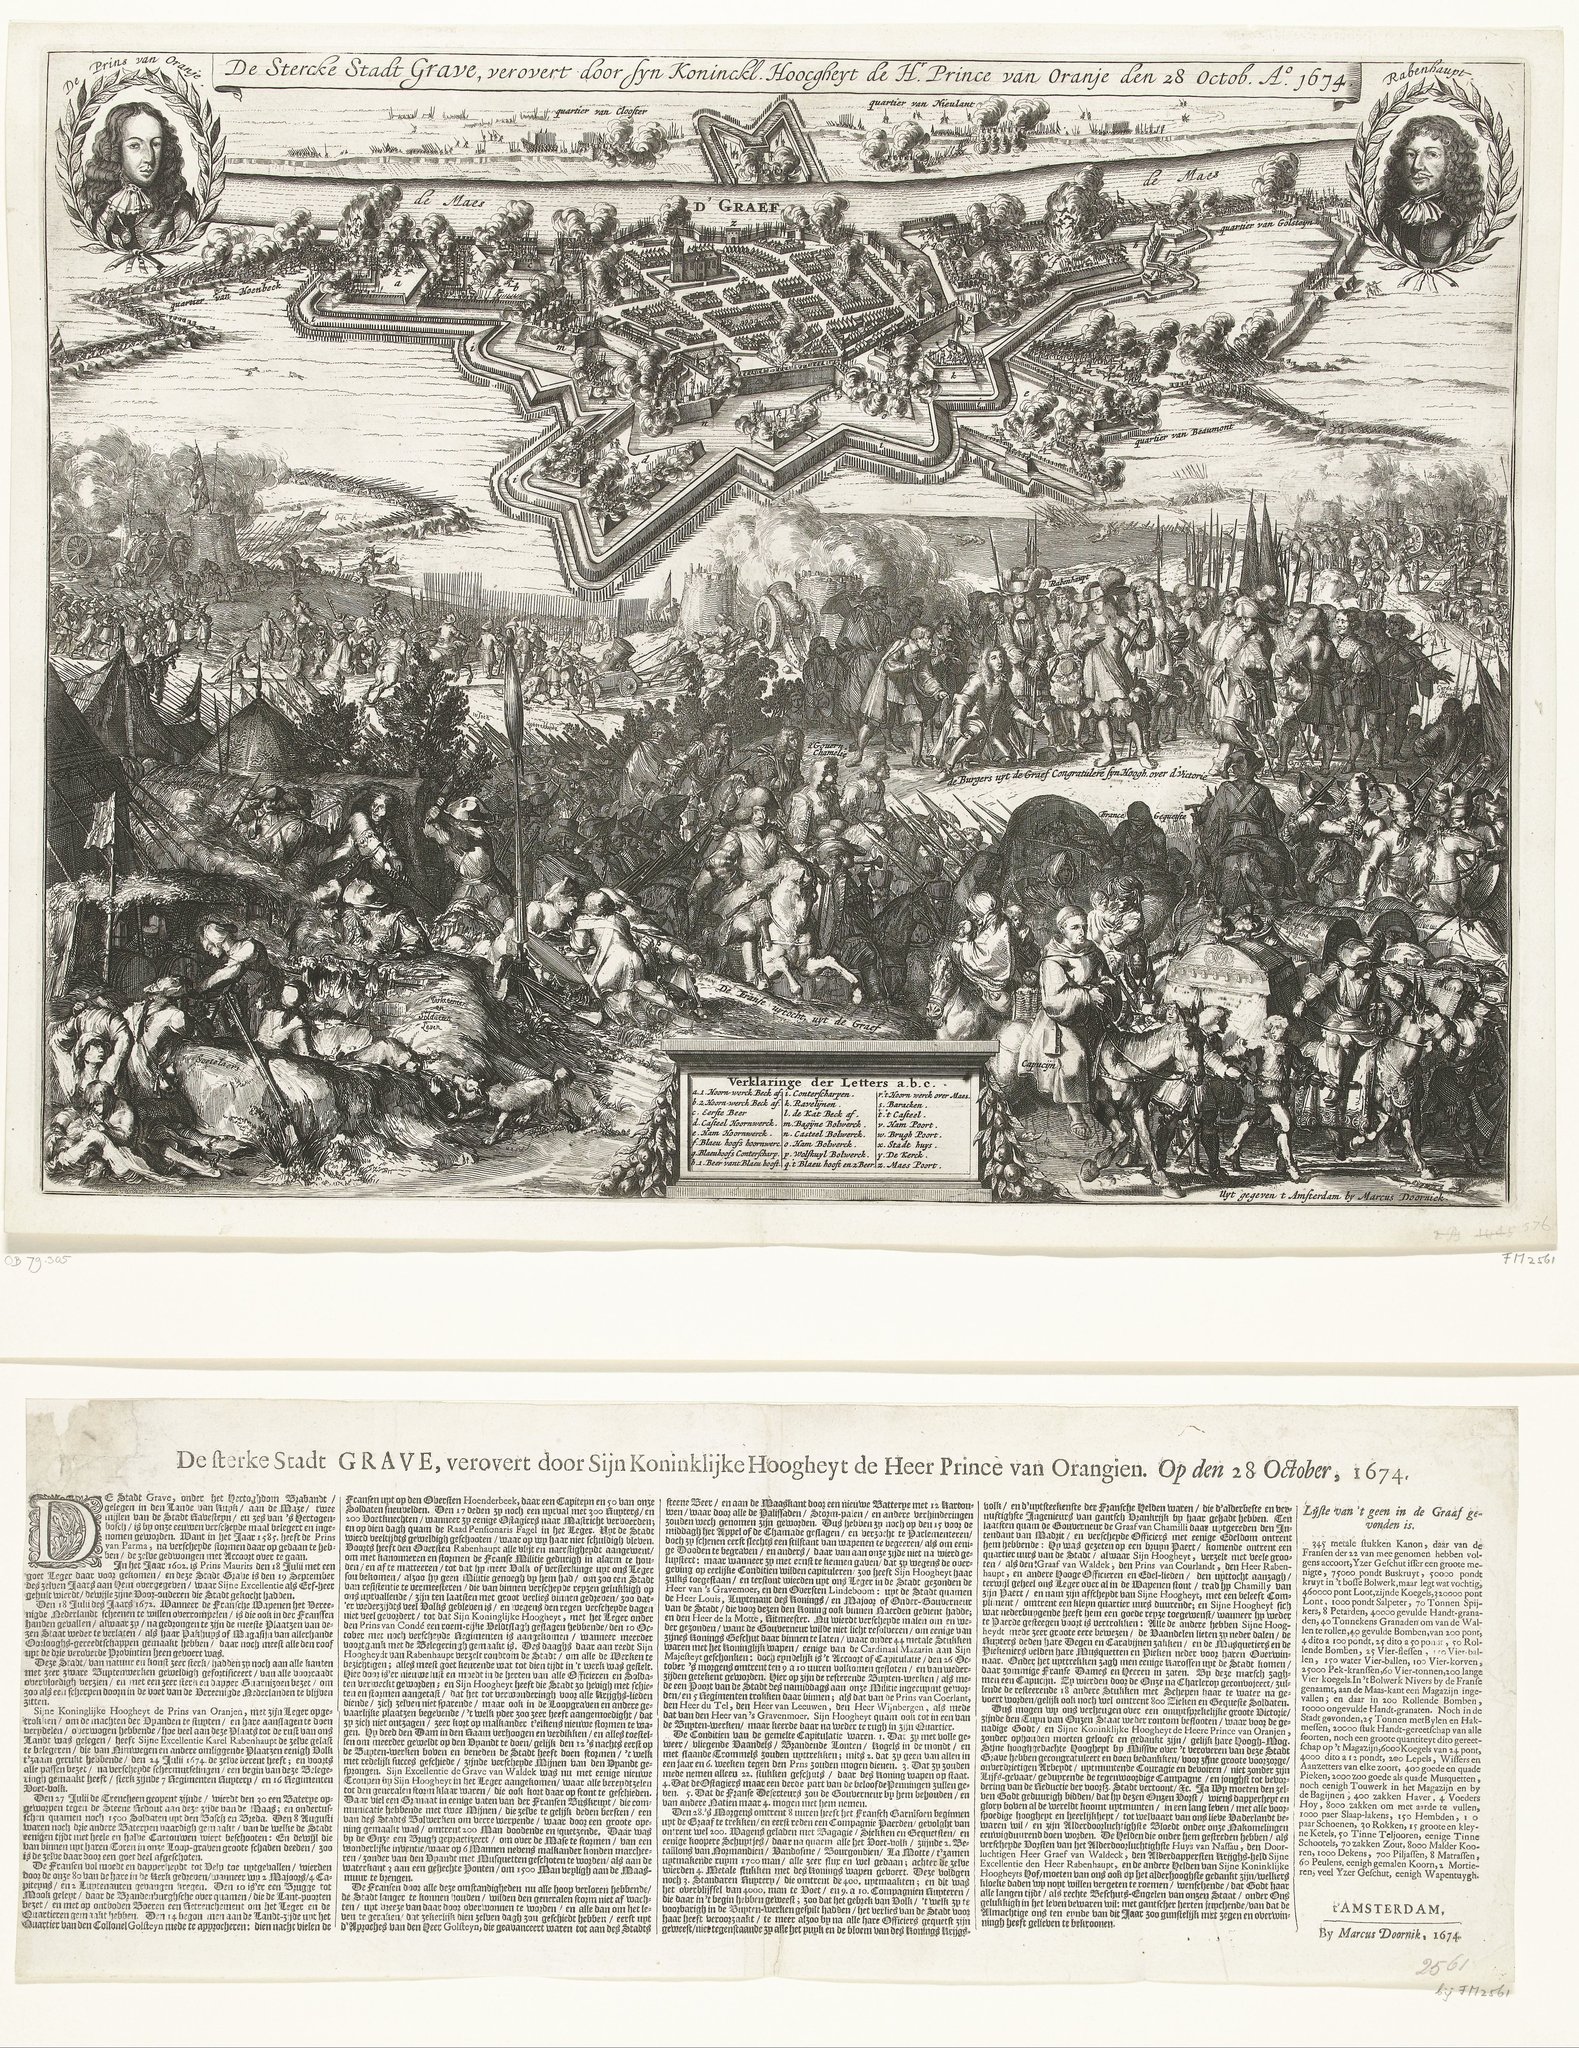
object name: print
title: De Stercke Stadt Grave, verovert door syn Koninckl. Hoocgheyt de Hr. Prince van Oranje den 28 Octob. Ao. 1674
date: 1674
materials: paper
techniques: engraving, etching, letterpress printing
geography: amsterdam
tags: william iii (prince of orange and king of england, scotland, and ireland), siege, position war, capture of city (after the siege), grave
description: Beleg en verovering van Grave door Willem III, 25 juli tot 29 oktober 1674. Boven een gezicht op de belegerde stad met aan weerszijden medaillons met portretten van Willem III en Rabenhaupt. Onder verlaten de Fransen de veroverde stad en knielen vertegenwoordigers van de stad voor de prins. Links scènes uit het leven in een legerkamp. Onderaan een cartouche met de legenda a-z. In de voorstelling meerdere opschriften, waarvan sommige onvoltooid of weggepolijst zijn. Bij de prent ook een los tekstblad met tekst in 5 kolommen.